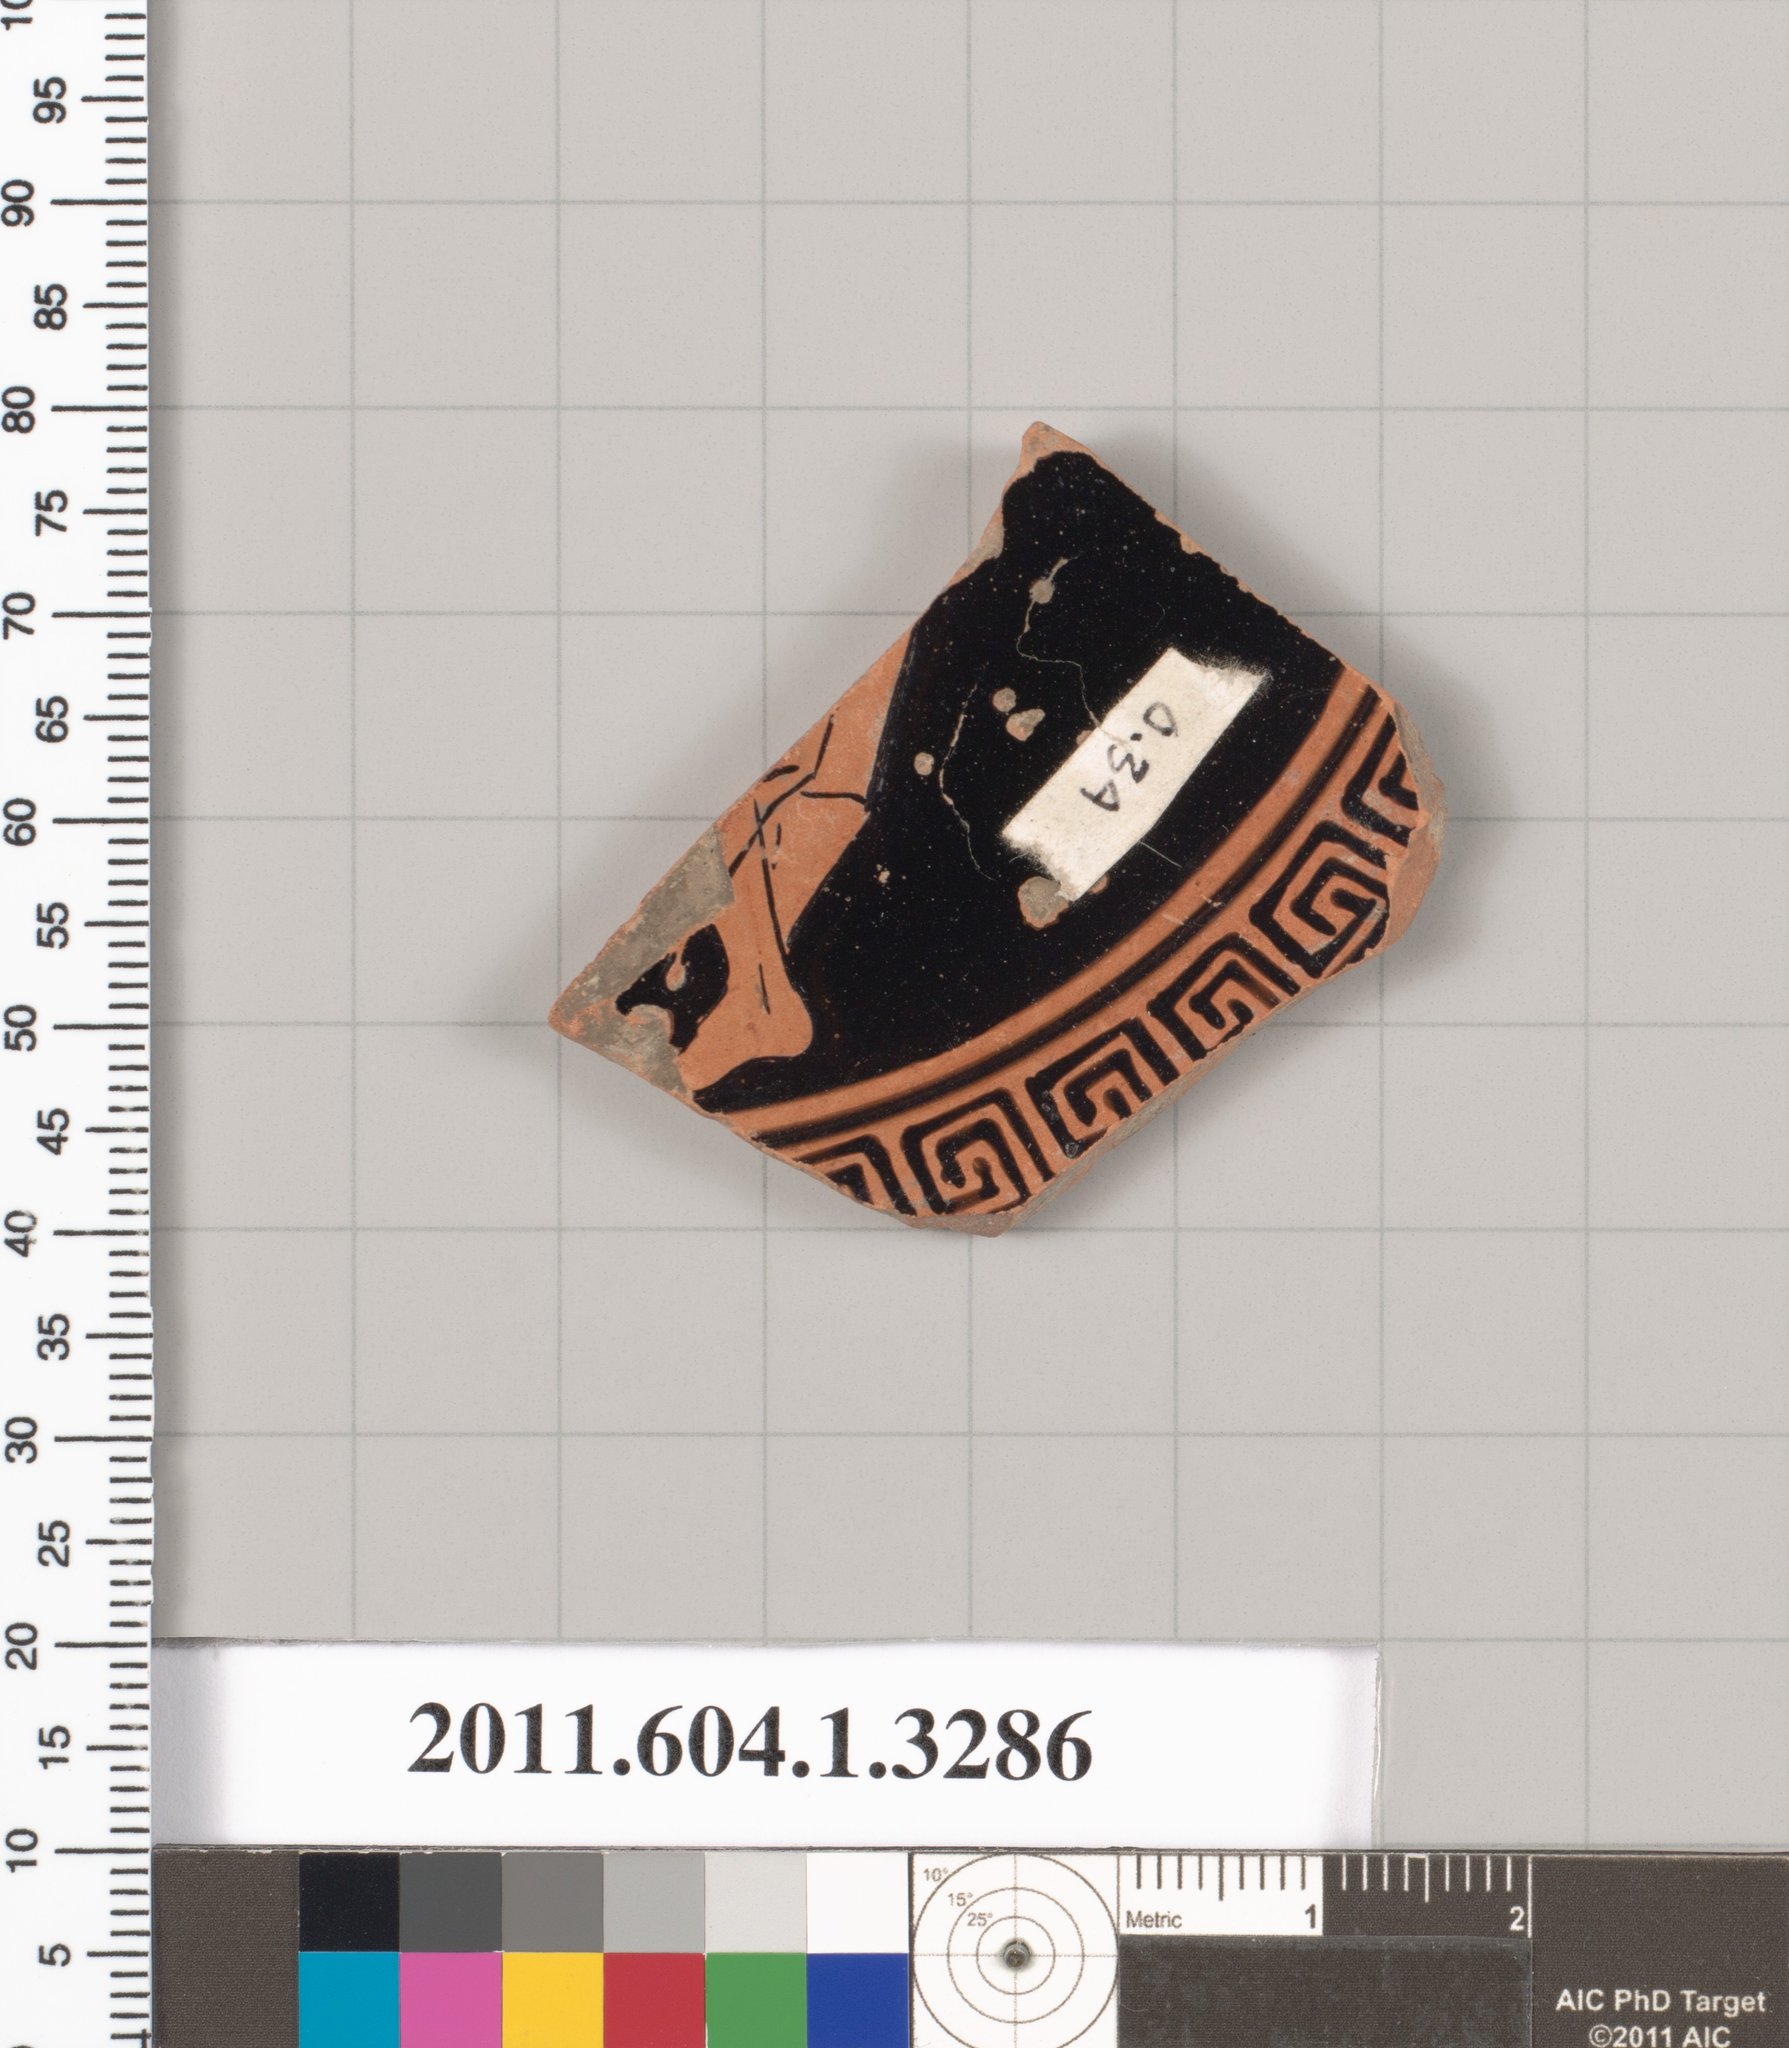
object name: kylix fragment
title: Terracotta fragment of a kylix (drinking cup)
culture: greek, attic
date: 490-470 BCE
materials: terracotta